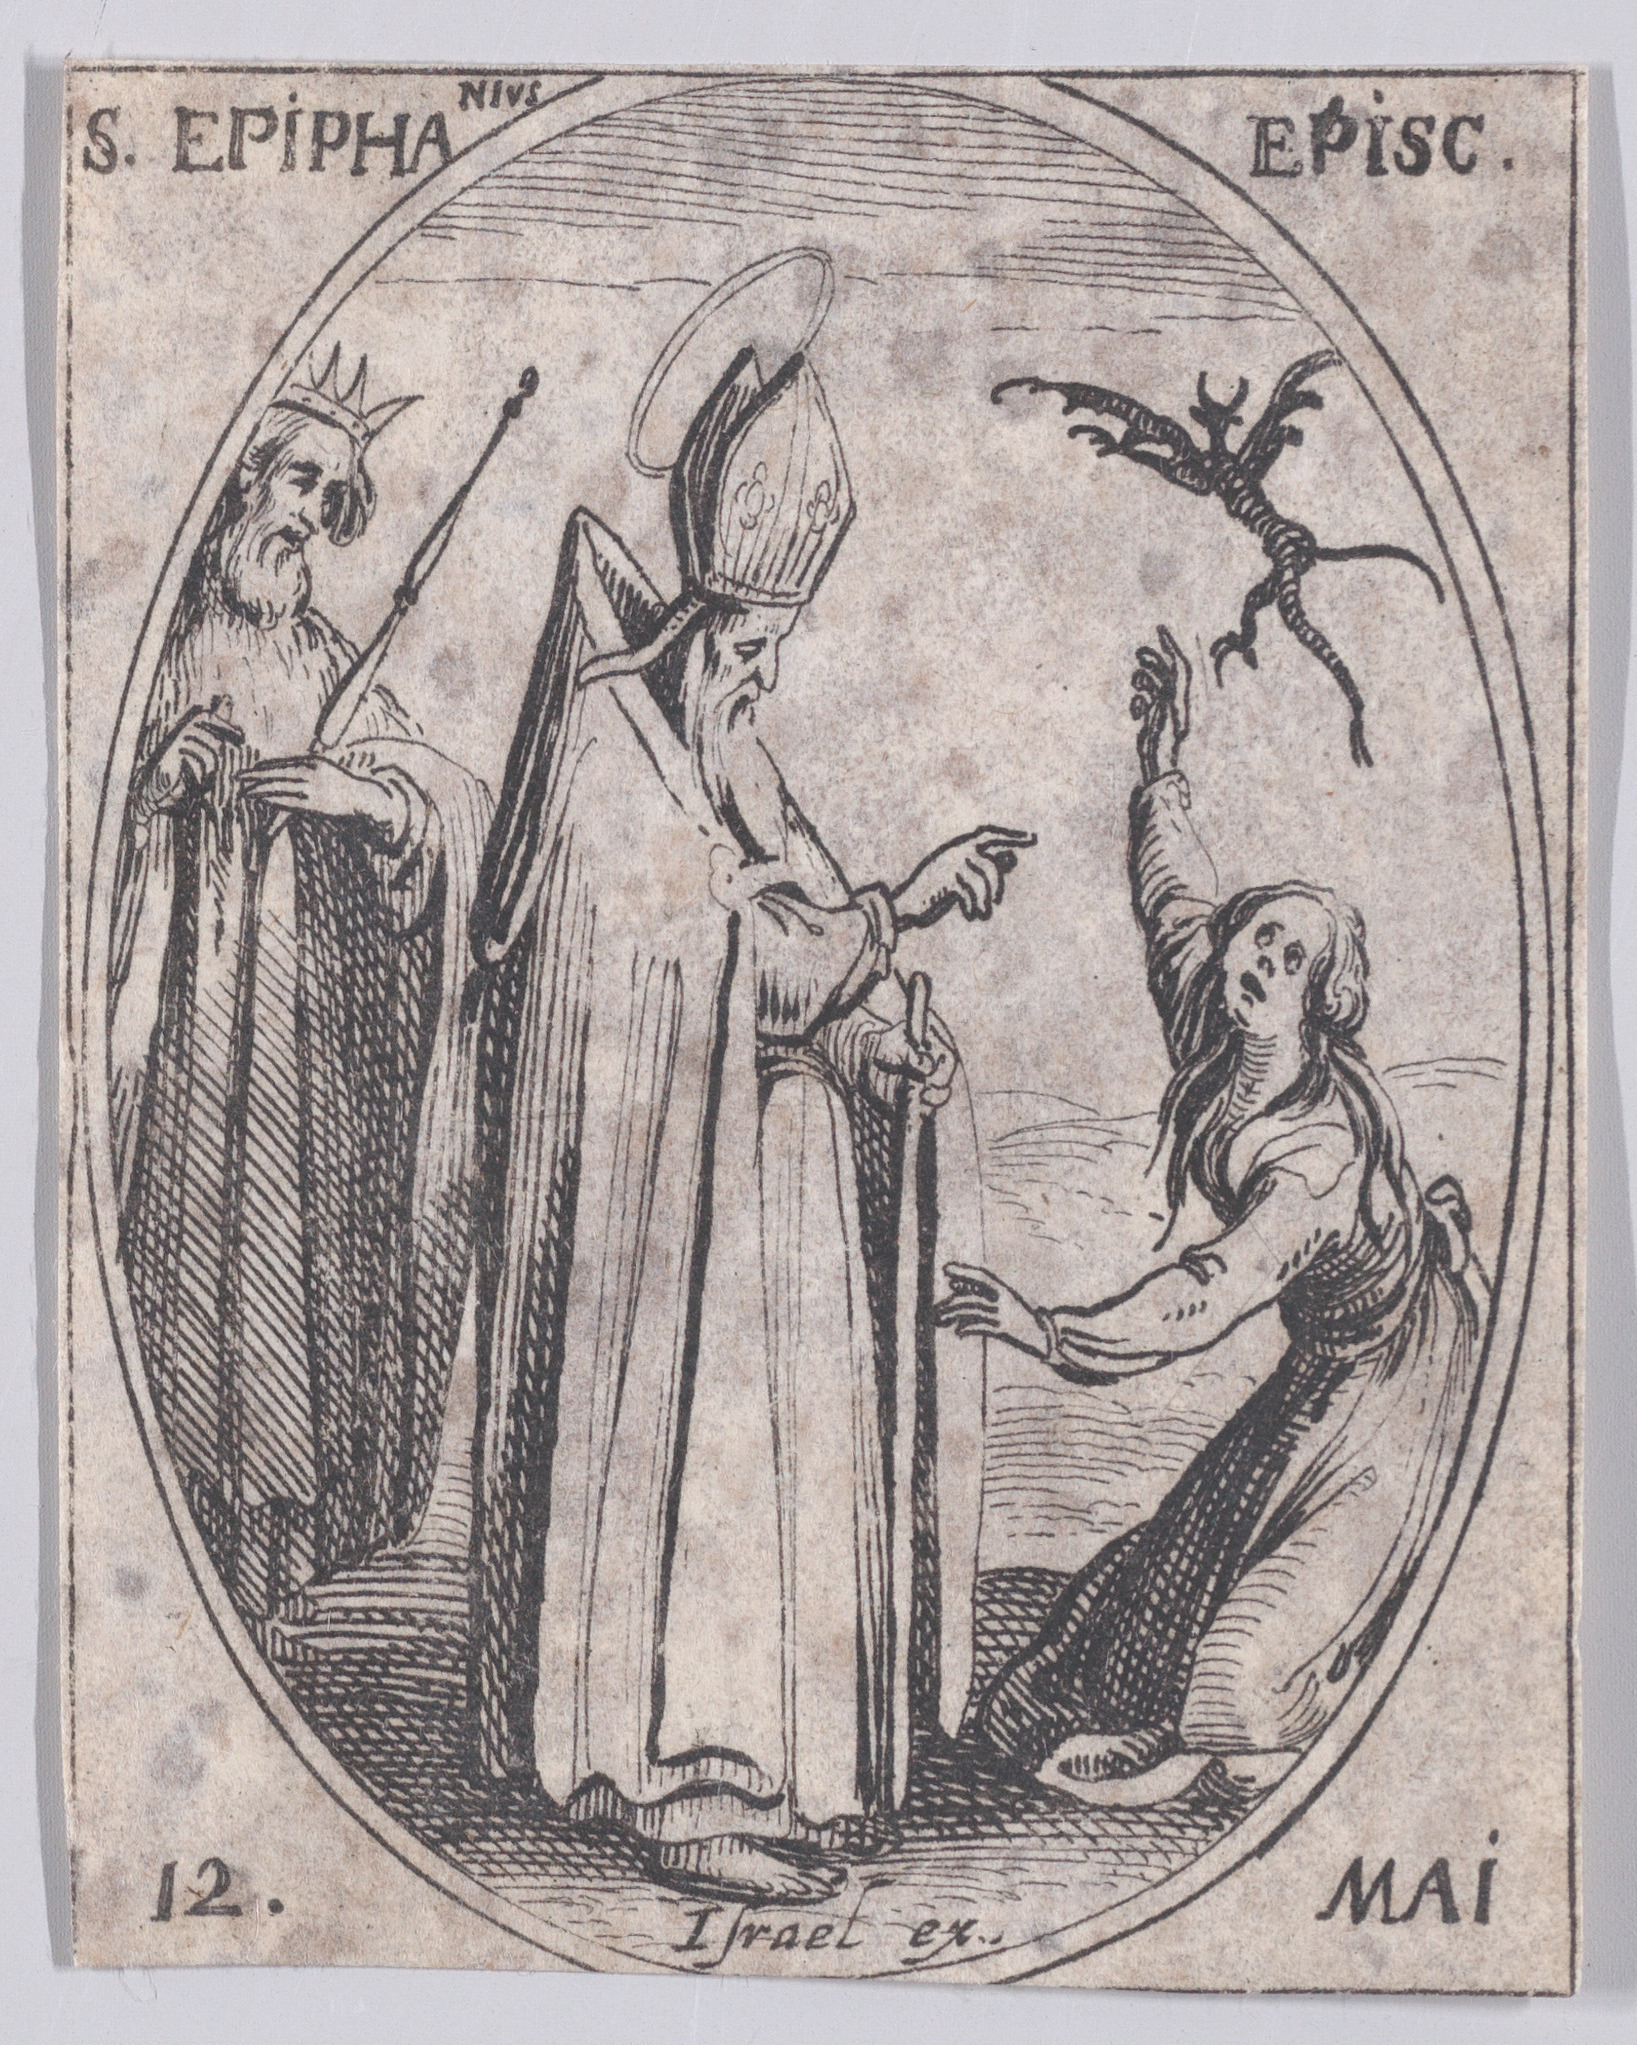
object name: print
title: S. Epiphane, évêque (St. Epiphanius, Bishop), May 12th, from "Les Images De Tous Les Saincts et Saintes de L'Année" (Images of All of the Saints and Religious Events of the Year)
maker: jacques callot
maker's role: artist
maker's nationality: french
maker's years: 1592-1635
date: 1636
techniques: etching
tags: men,women,saints